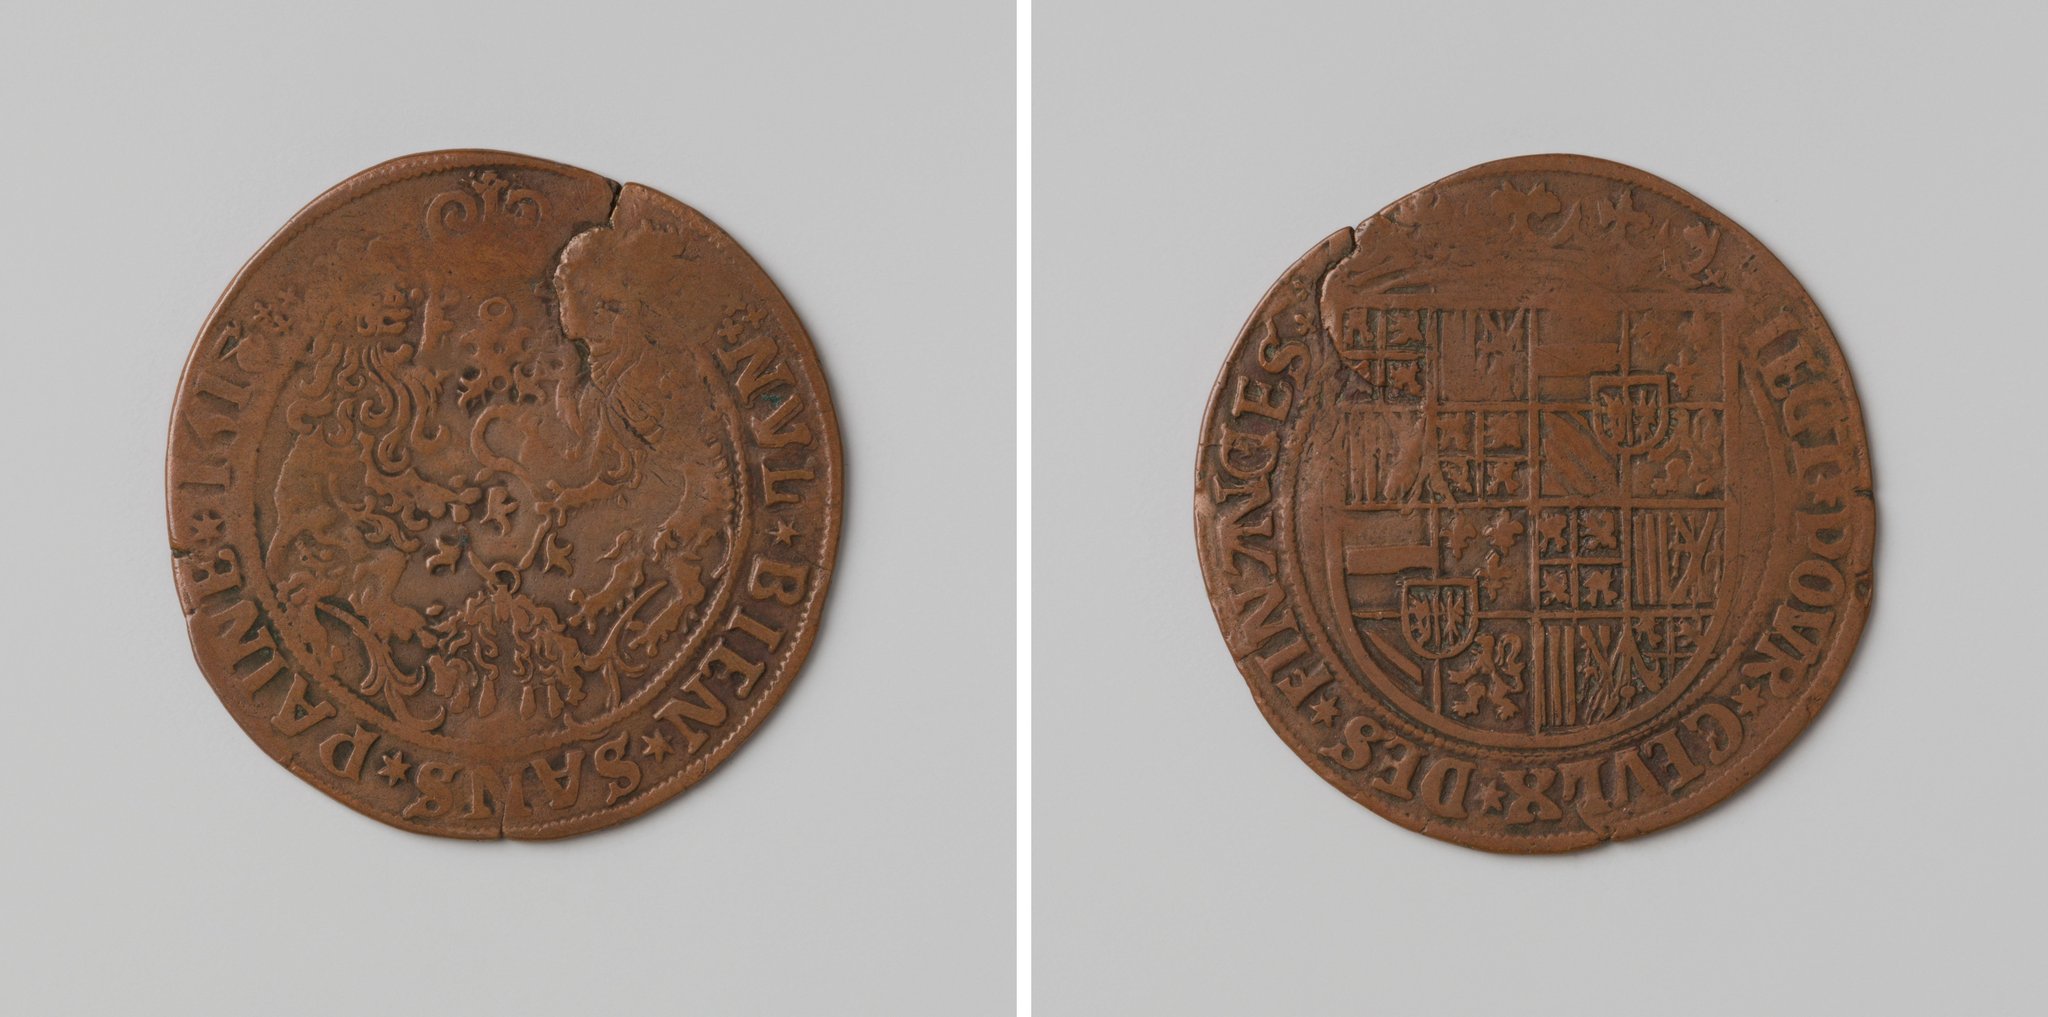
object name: jeton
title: Landing van Karel I bij Tazones in Spanje, rekenpenning van de raad van Financien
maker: Anonymous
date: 1518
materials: copper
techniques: striking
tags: ghent, charles v (holy roman emperor and king of spain)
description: Koperen penning. Voorzijde: twee naar elkaar gewende leeuwen dragen vuurslag, waar Gulden Vlies aanhangt binnen omschrift. Keerzijde: gekroond wapenschild binnen omschrift